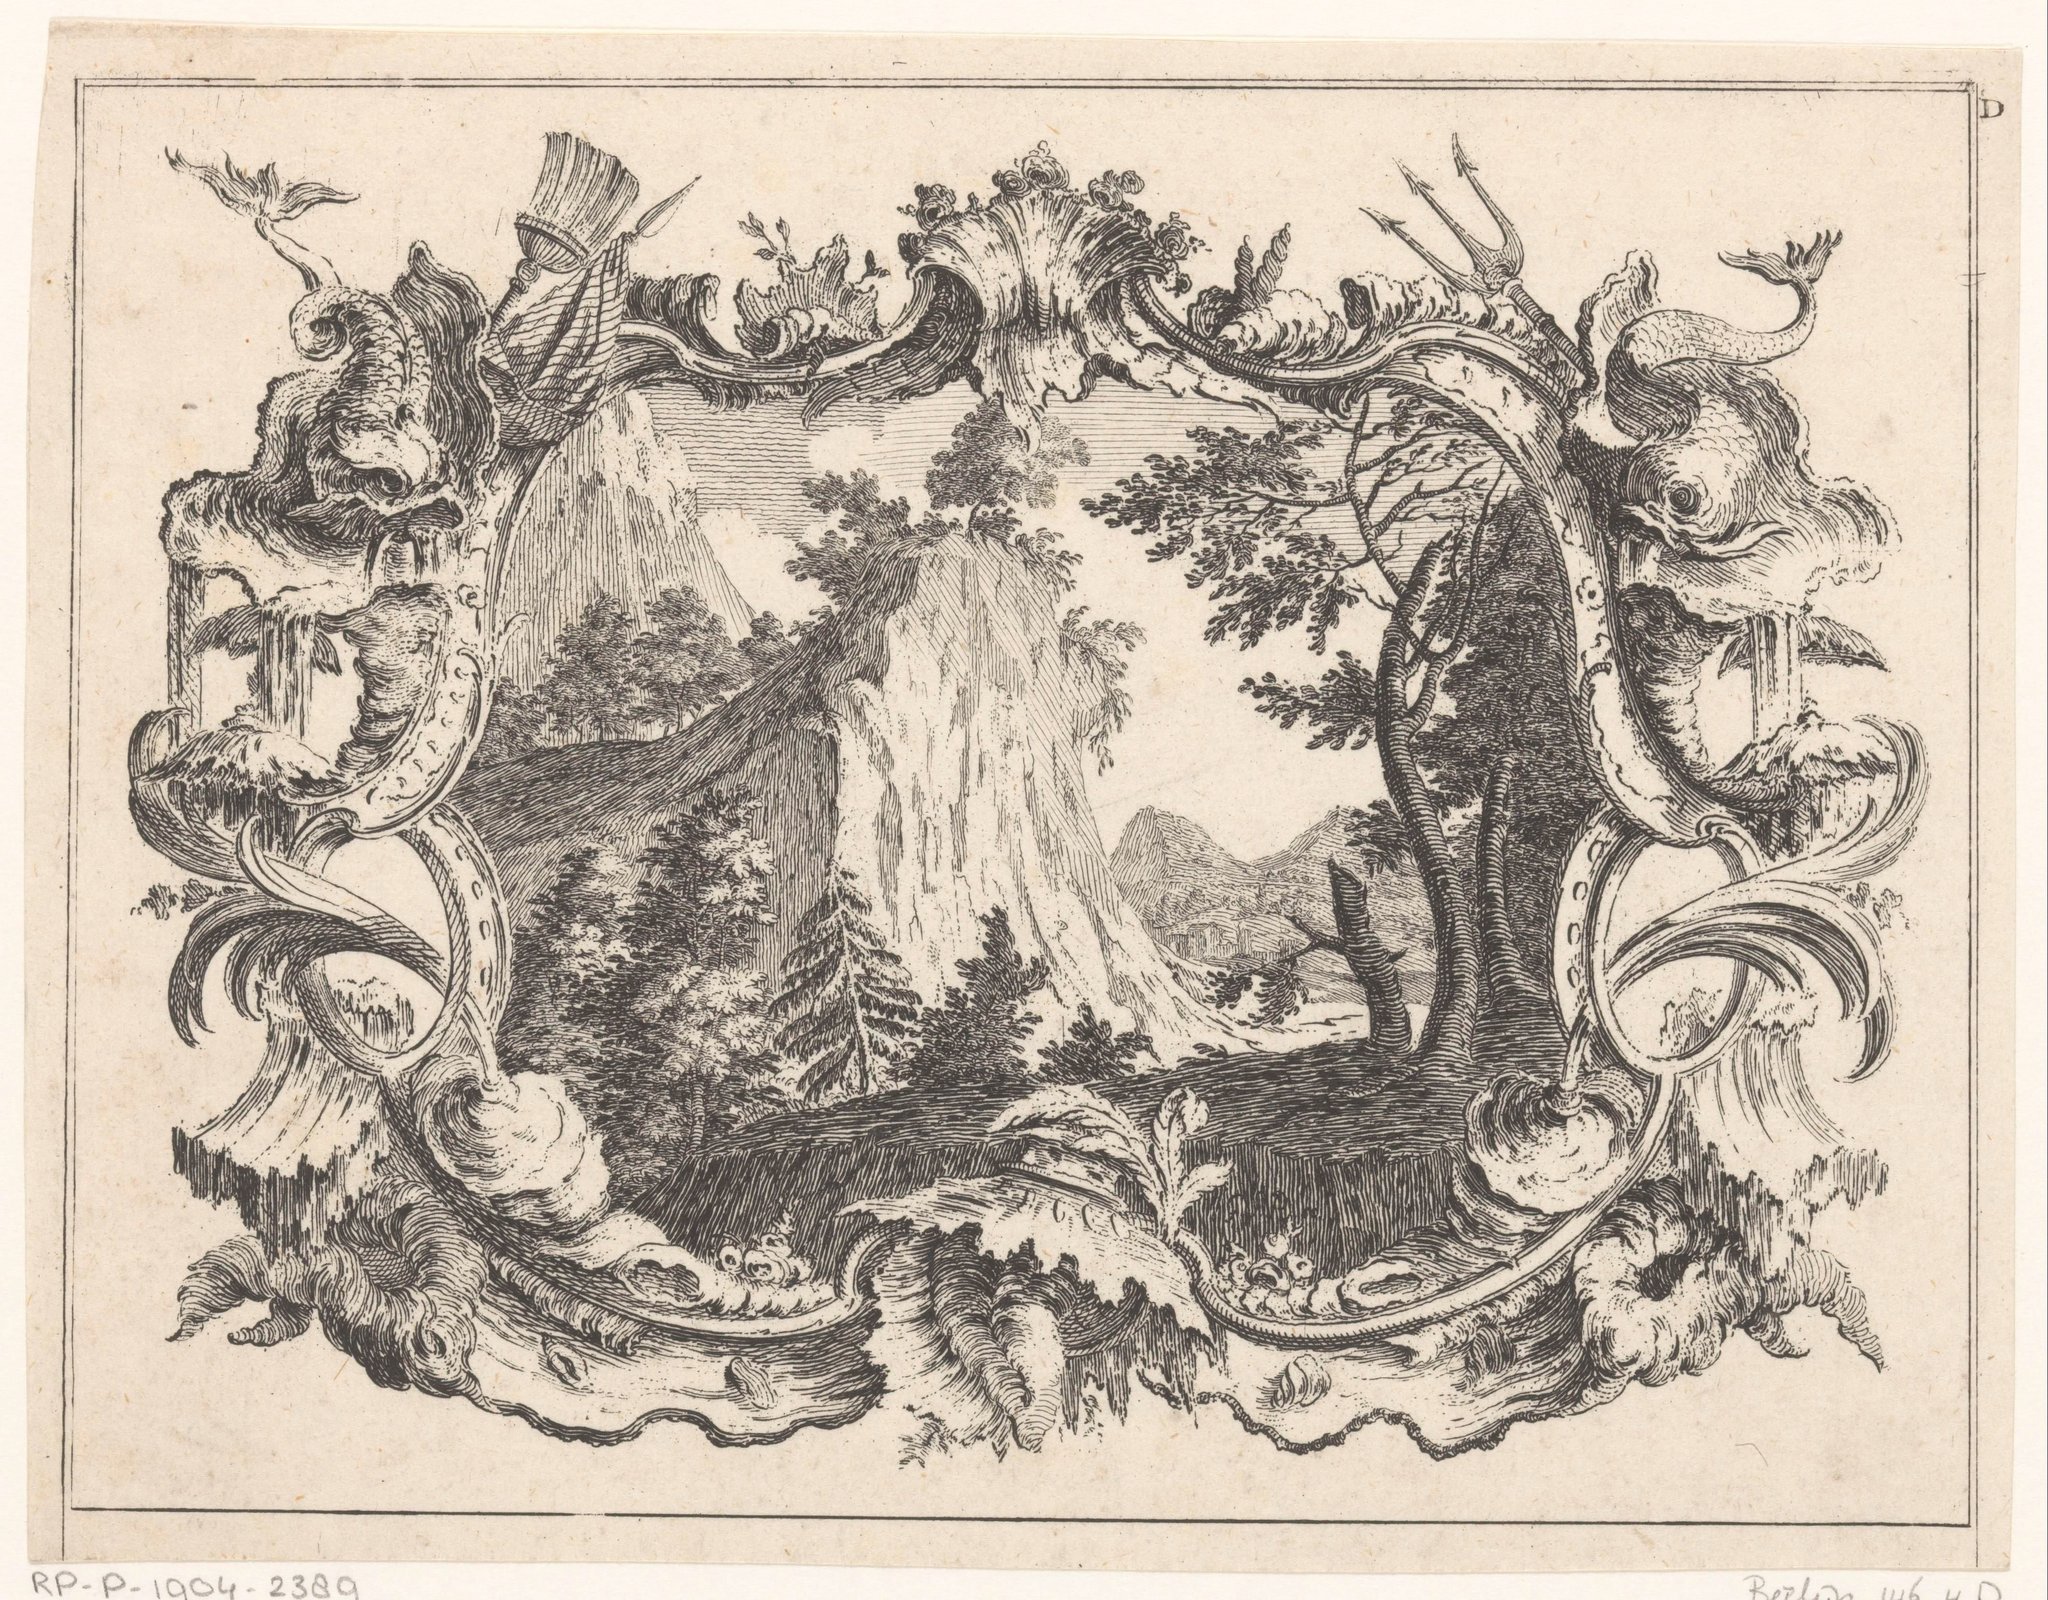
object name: print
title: Figuren in landschappen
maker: carl albert von lespilliez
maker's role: print maker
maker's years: 1723-1796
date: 1745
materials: paper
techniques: etching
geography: germany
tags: dolphin ~ ornament, mountains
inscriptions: collector's mark: Lugt 2228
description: Een berglandschap met bomen, rondom een omlijsting met dolfijnen.